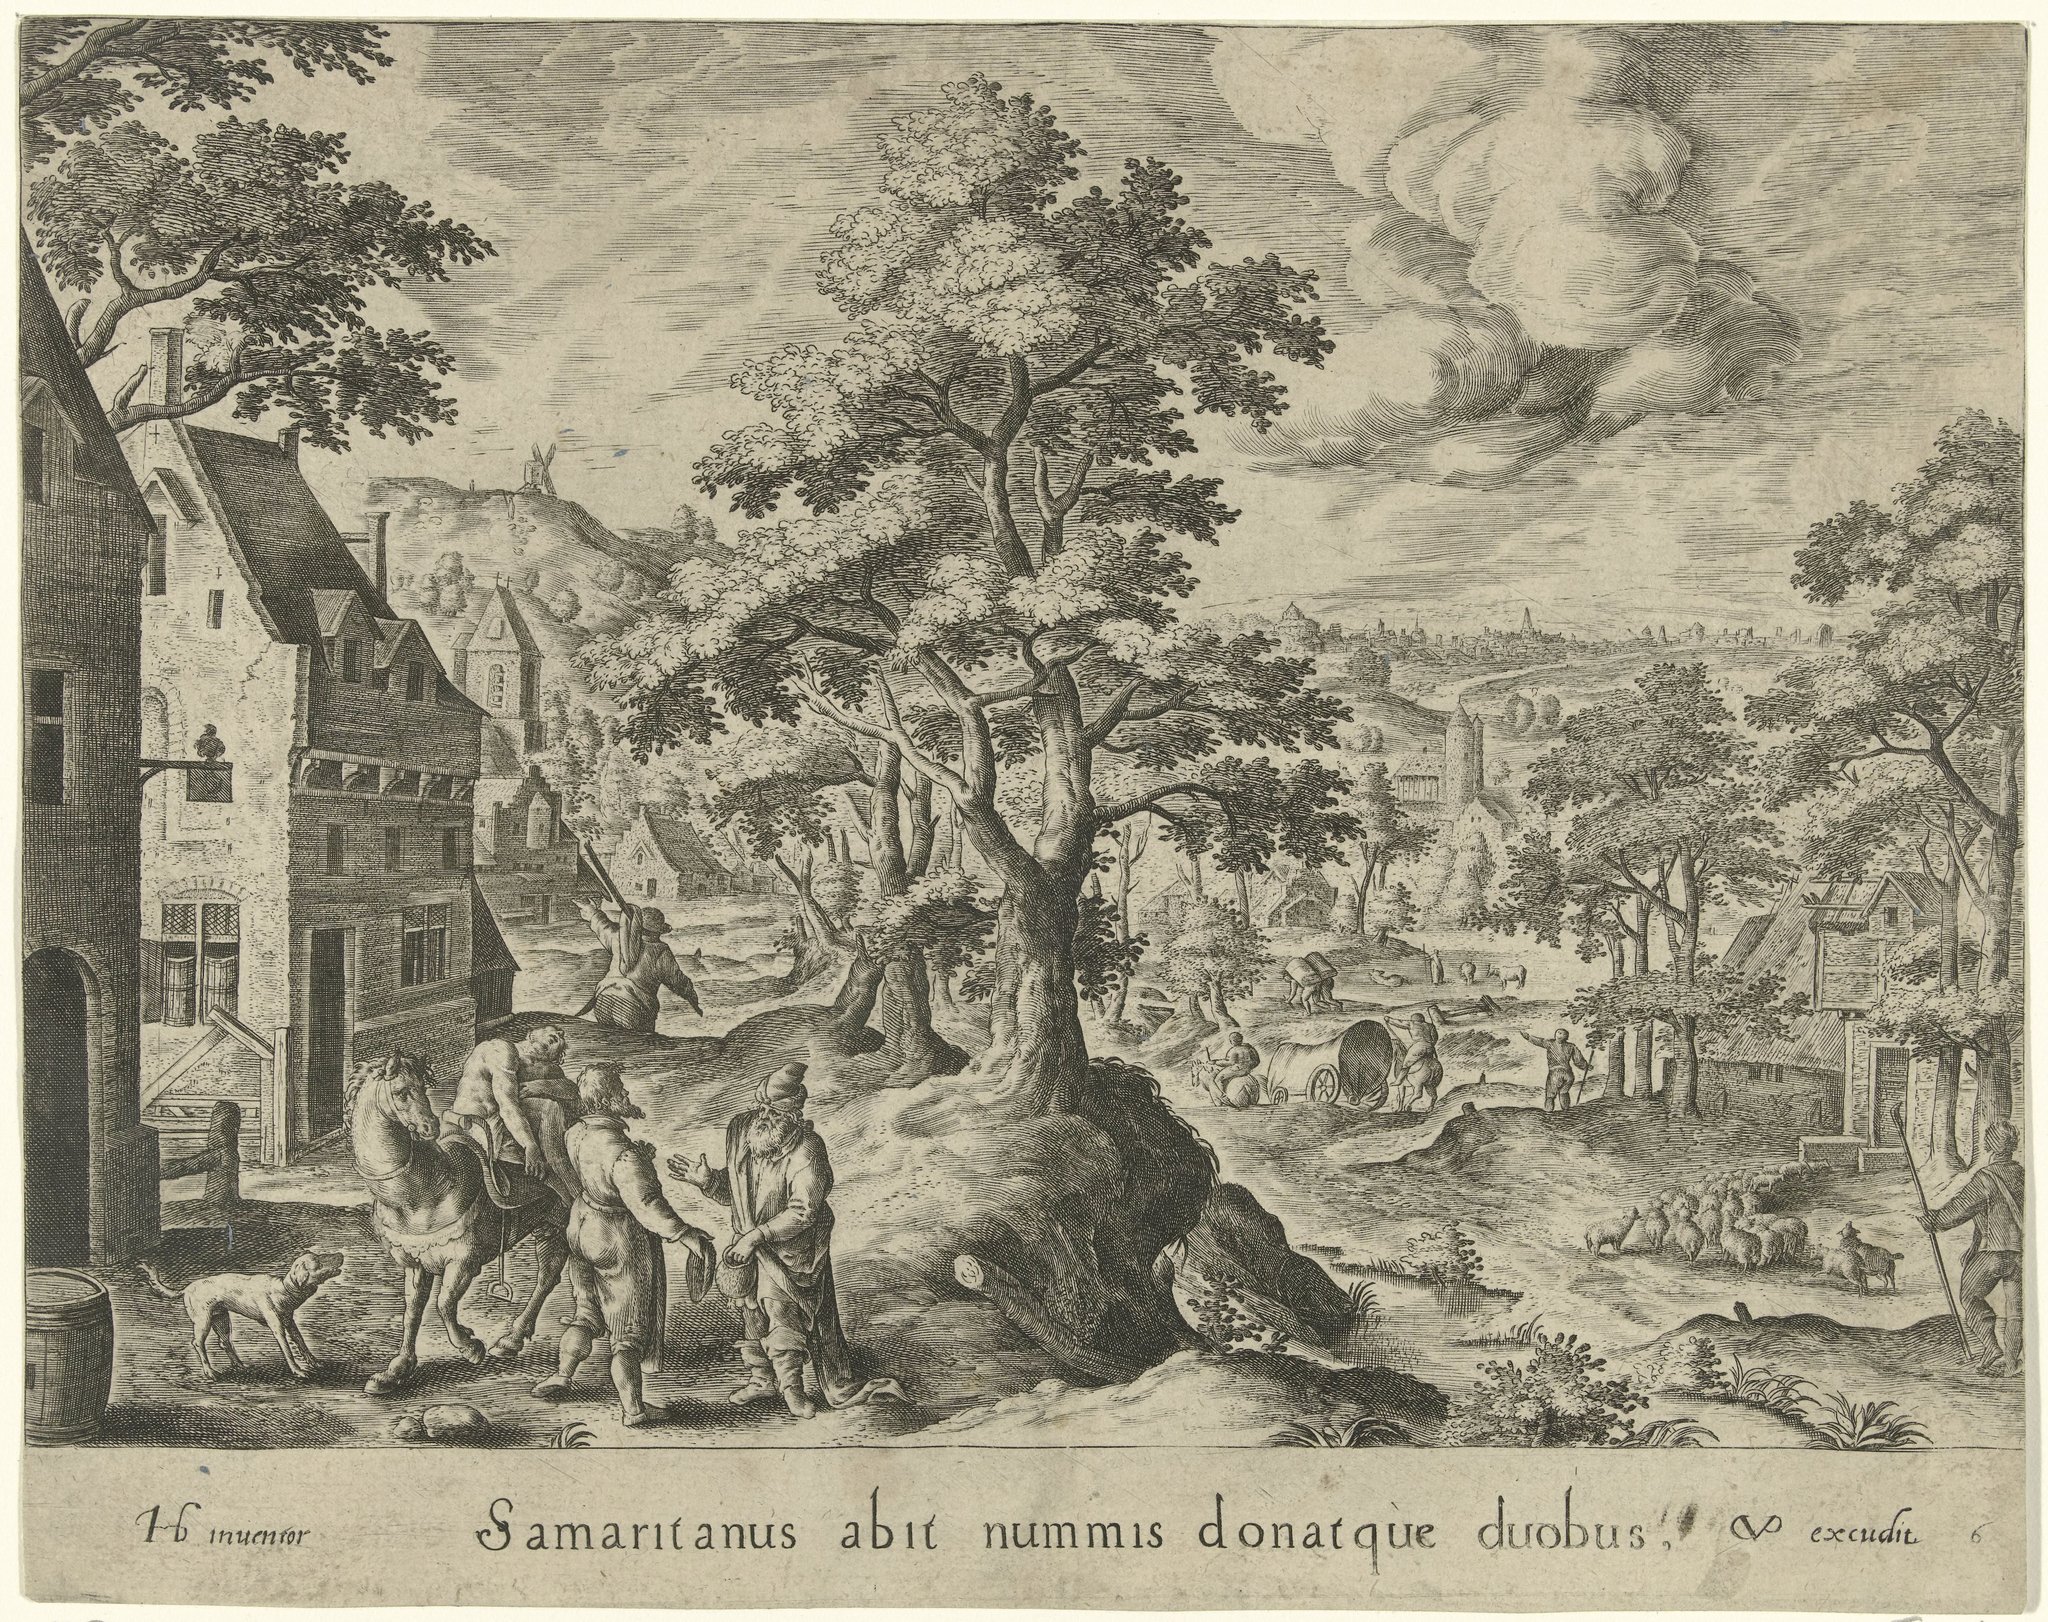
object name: print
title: Landschappen met scènes uit de gelijkenis van de barmhartige Samaritaan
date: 1588-1589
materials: paper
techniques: engraving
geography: aachen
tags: the samaritan and the wounded traveller arrive at the inn; the traveller is cared for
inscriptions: collector's mark: Lugt 2228, collector's mark: Lugt 1337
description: De barmhartige Samaritaan betaalt een herbergier om de gewonde reiziger verder te verplegen. In de marge een regel in het Latijn.